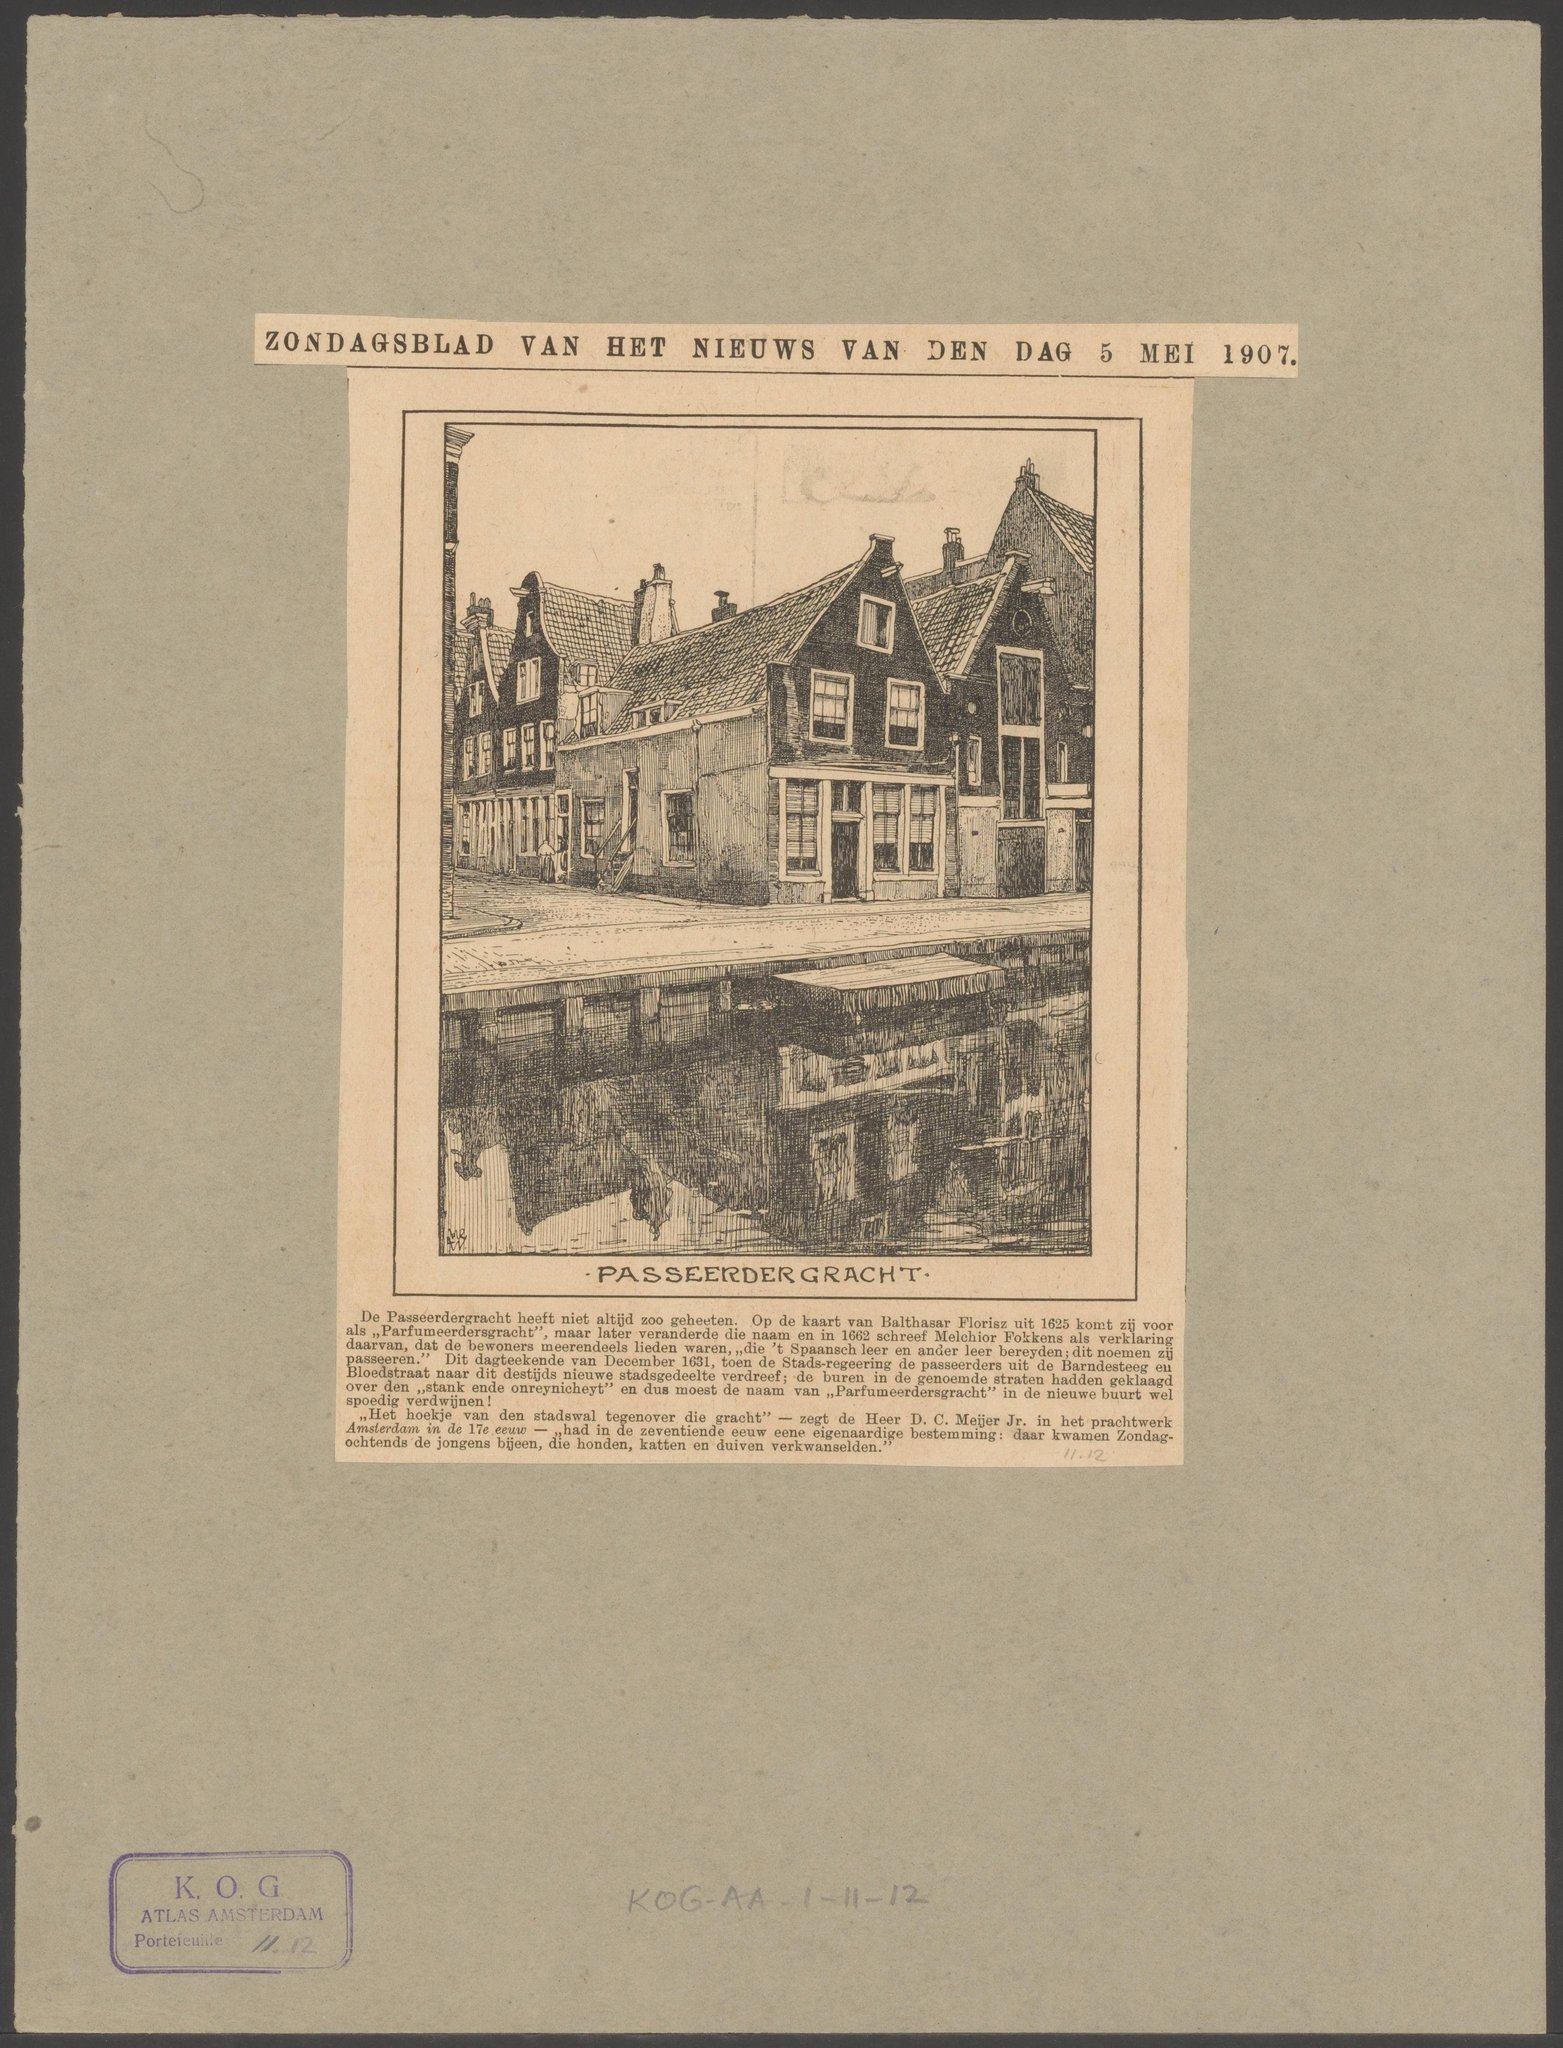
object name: photomechanical print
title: Gezicht op de Passeerdersgracht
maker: willem wenckebach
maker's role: designer, draughtsman, painter, print maker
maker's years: 1860-1937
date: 1907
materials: paper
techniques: letterpress printing, line block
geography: amsterdam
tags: city-view in general; 'veduta', canal, the usual house or row of houses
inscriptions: collector's mark: ‘11.12’ Lugt 1641b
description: Onderwerpsrubriek binnen de Atlas Amsterdam: Paleisstraat, Palmgracht, Papenbrugsteeg, Passeerdersgracht, Peperstraat, Pieterspoort (St.), Pieterssteeg (St.), Plantage, Prinseneiland.